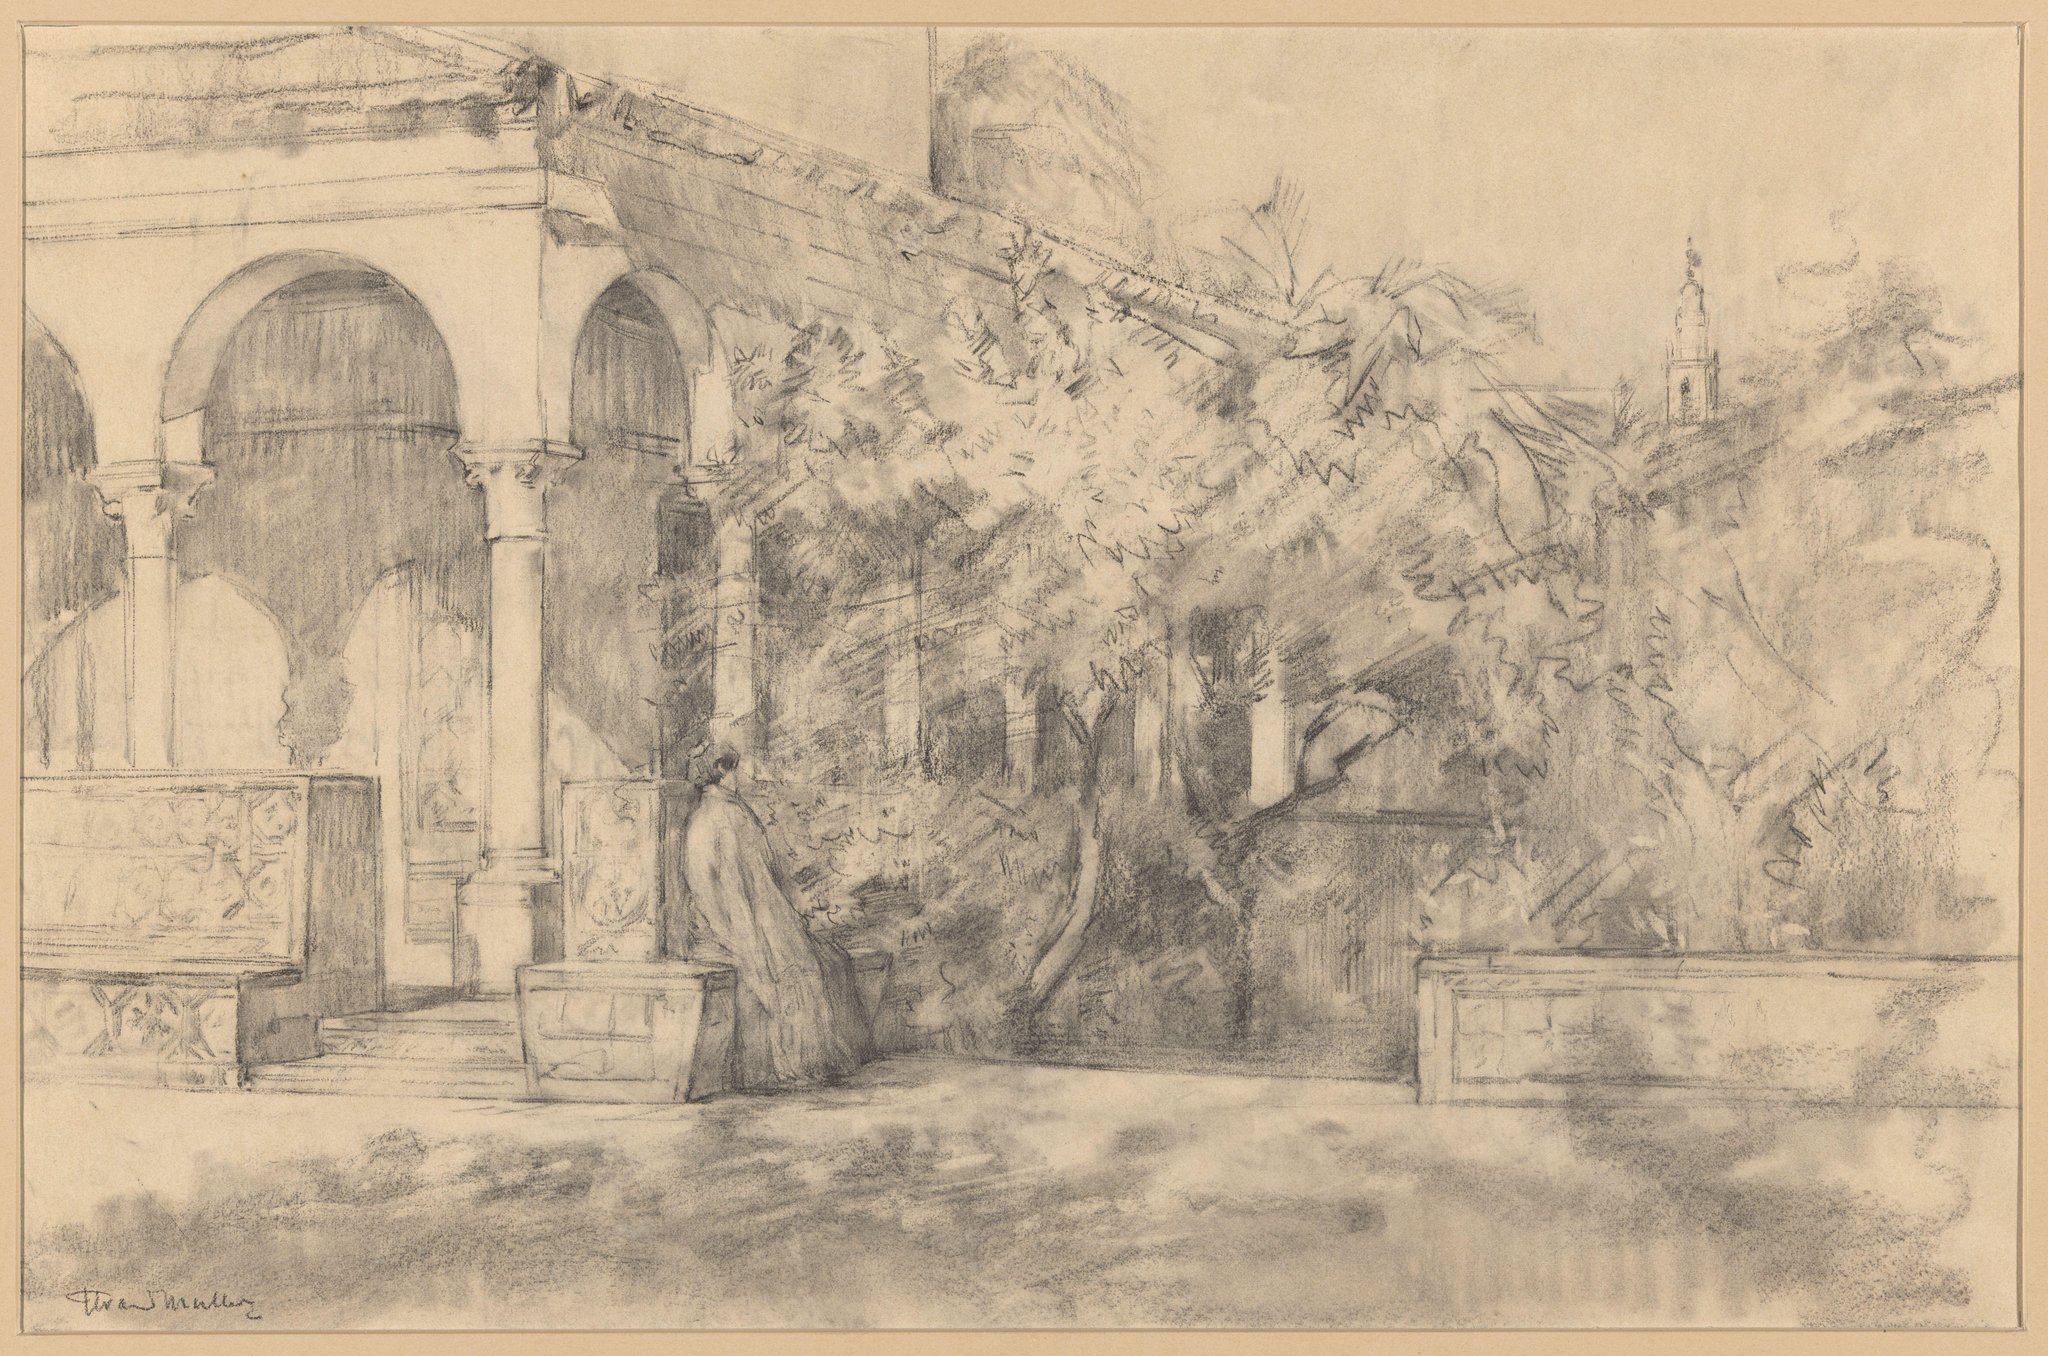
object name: drawing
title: Paviljoen van Karel V in het Koninklijk Paleis te Sevilla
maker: gerard muller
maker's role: draughtsman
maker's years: 1861-1929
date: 1871-1903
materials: chalk, paper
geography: sevilla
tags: palace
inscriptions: label: ‘25. Alcázar Sevilla/ Pavilloen Karel V’, collector's mark: Lugt 2228